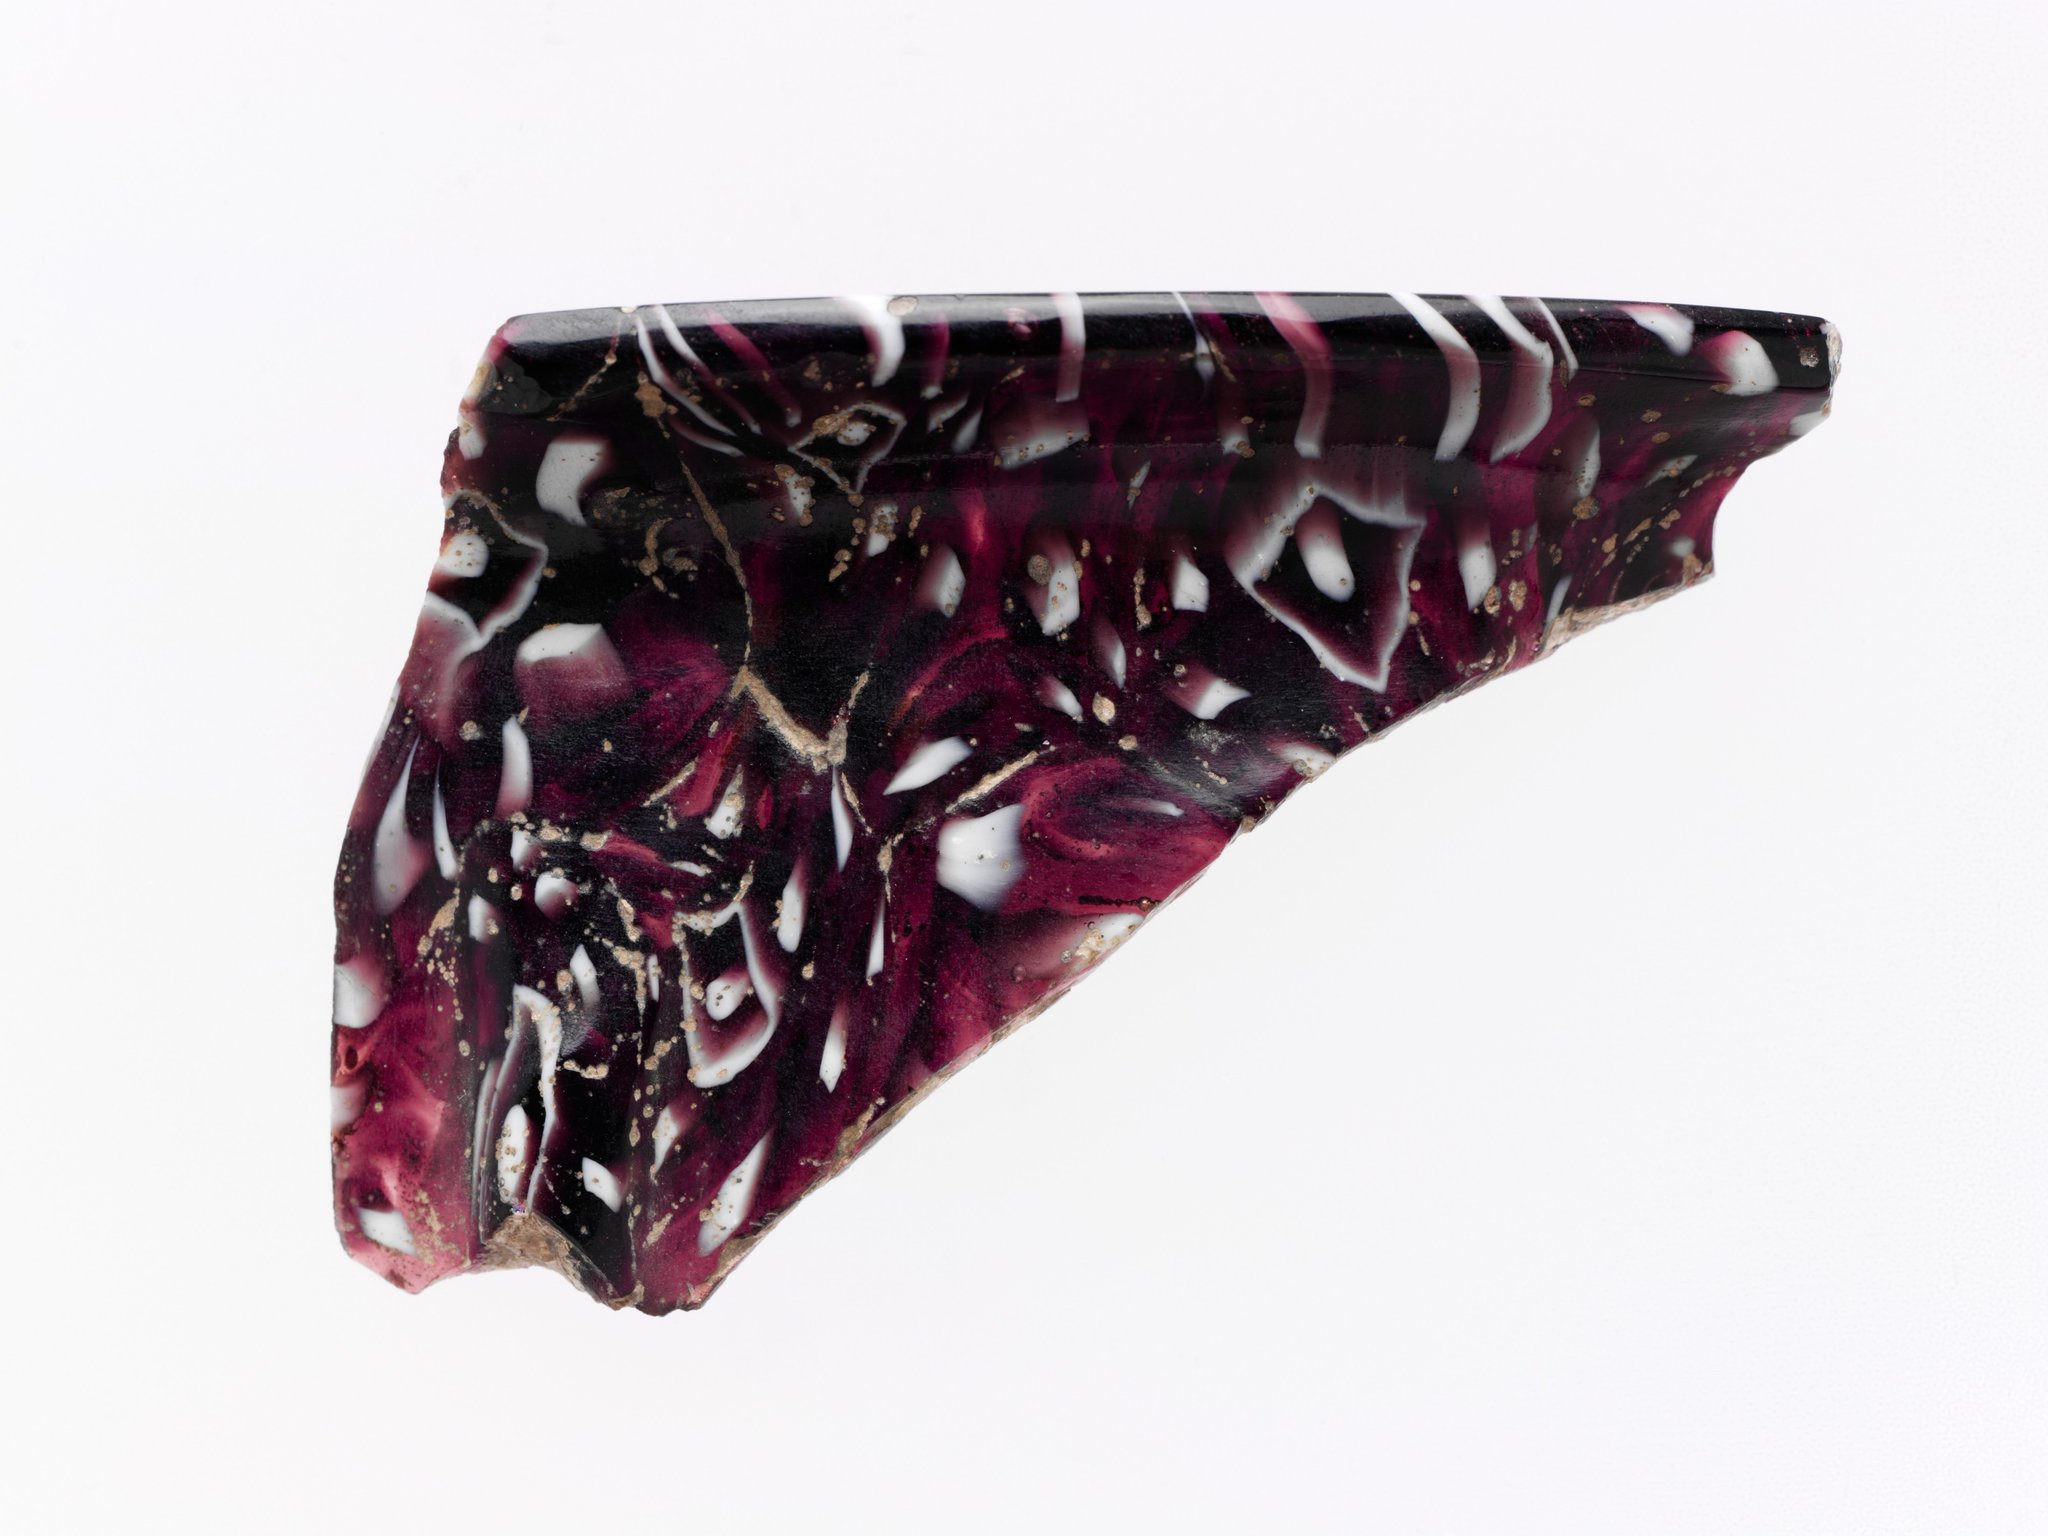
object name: fragment, mosaic bowl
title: Glass mosaic ribbed bowl fragment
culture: roman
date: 34 BCE-33 CE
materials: glass